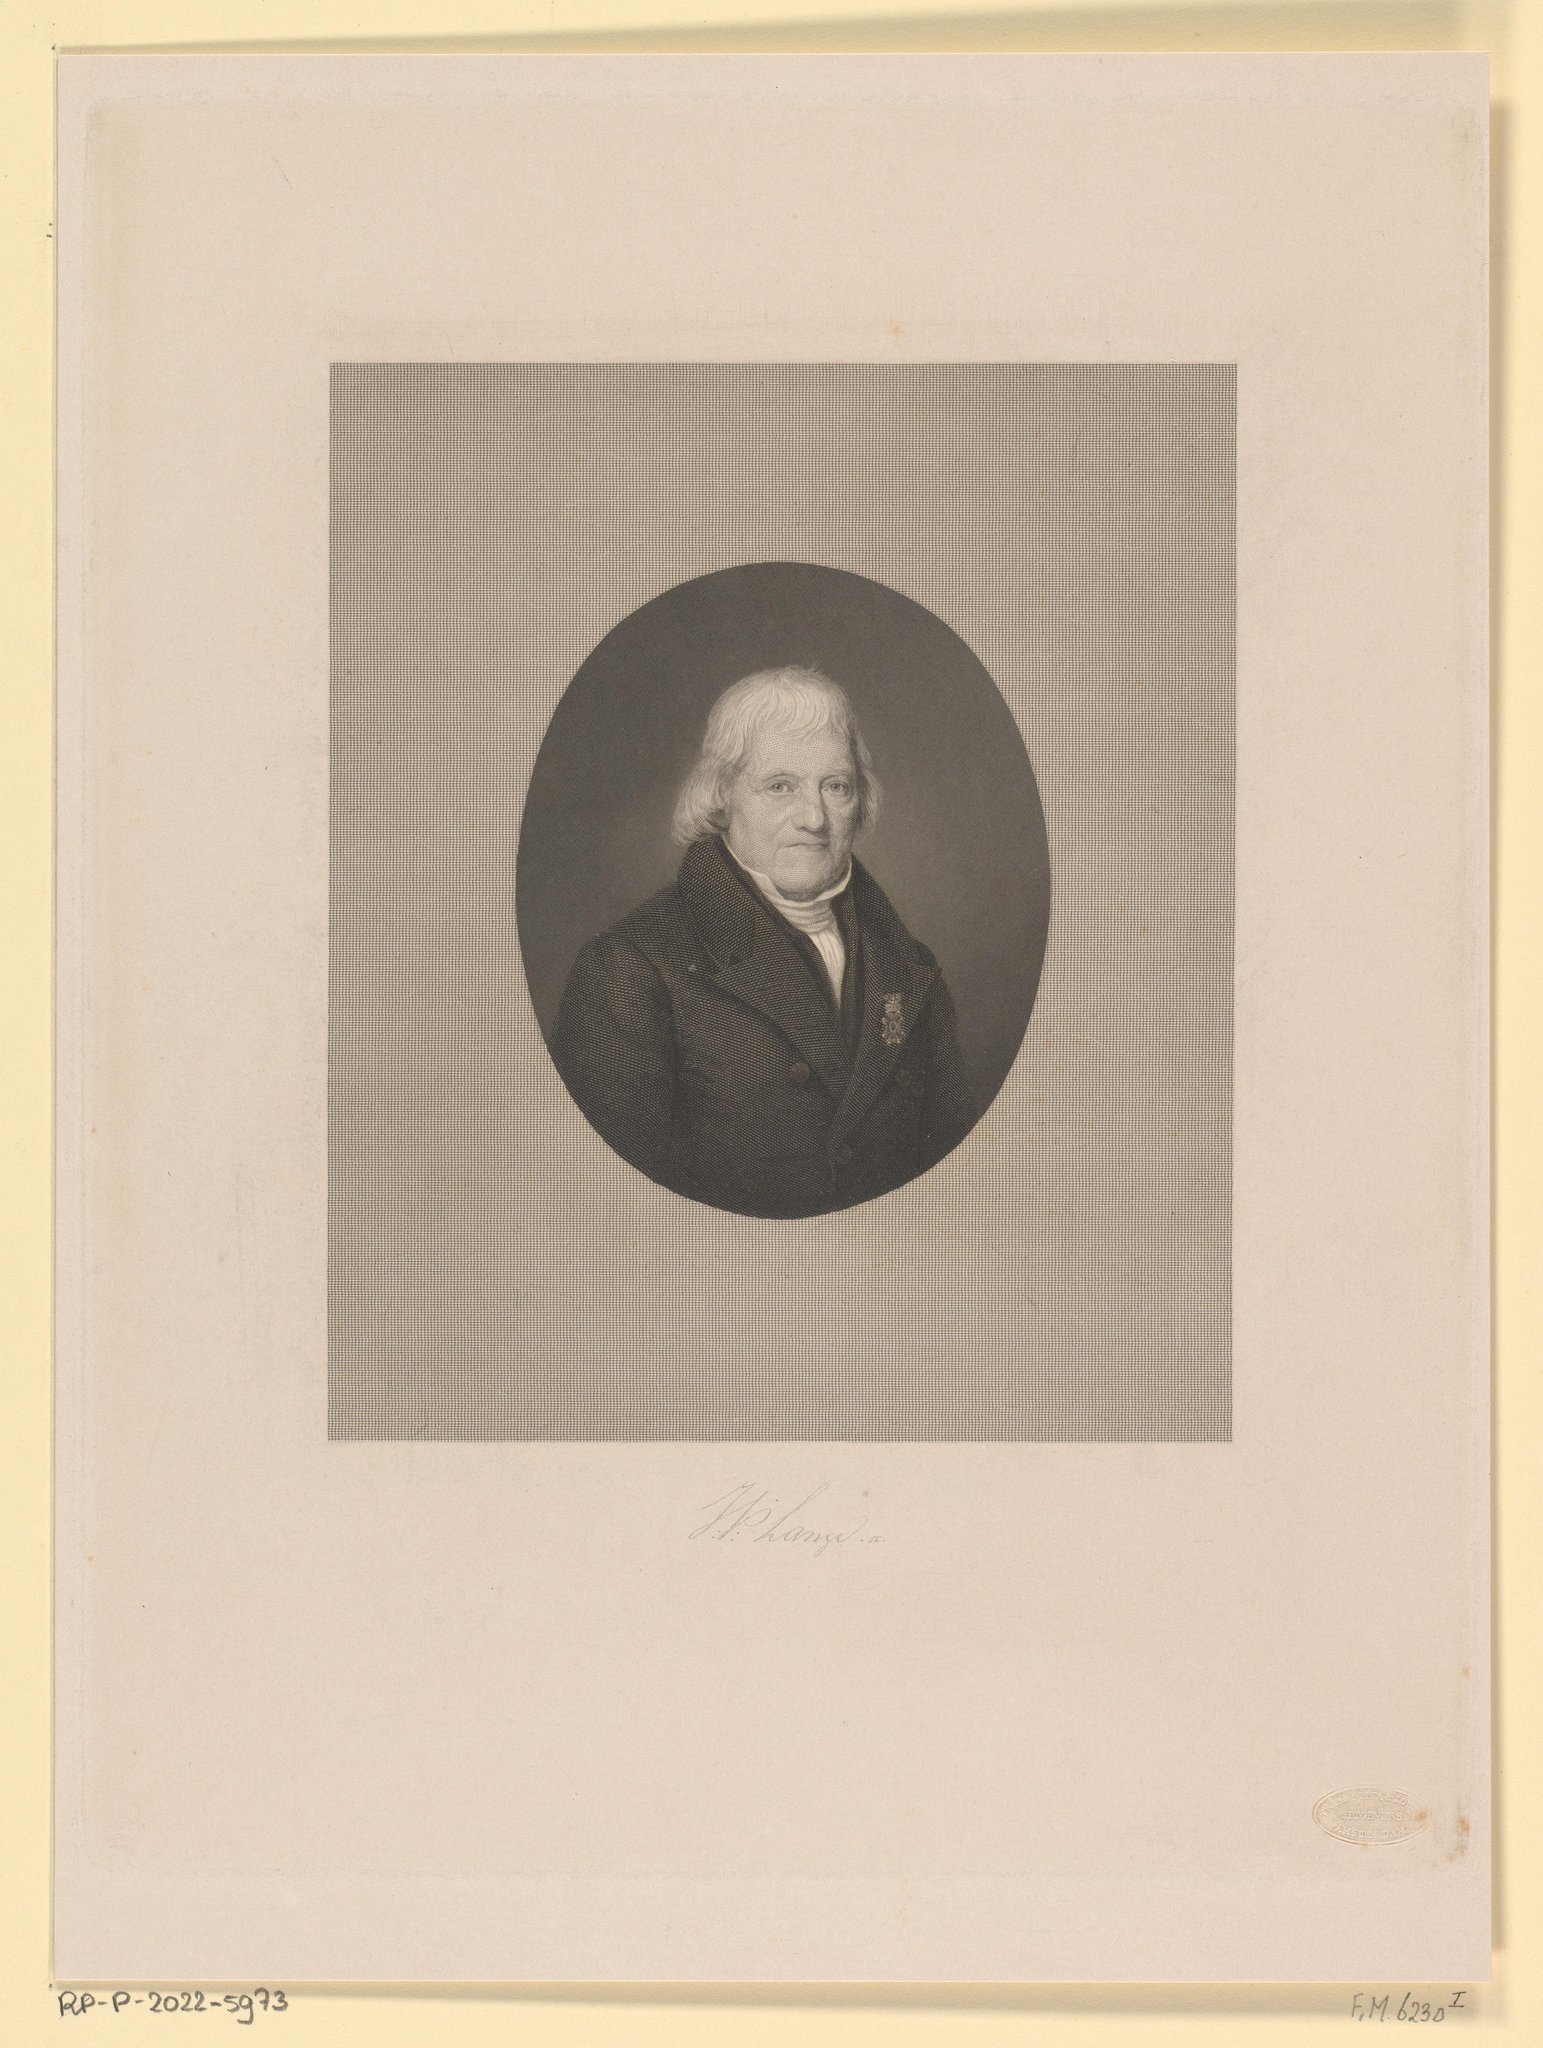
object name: print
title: Portret van Johannes Leonardus Wolterbeek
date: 1846-1848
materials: paper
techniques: engraving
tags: knighthood order, historical persons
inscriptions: check stamp: ‘Frans Buffa & Zonen Uitgevers Amsterdam’